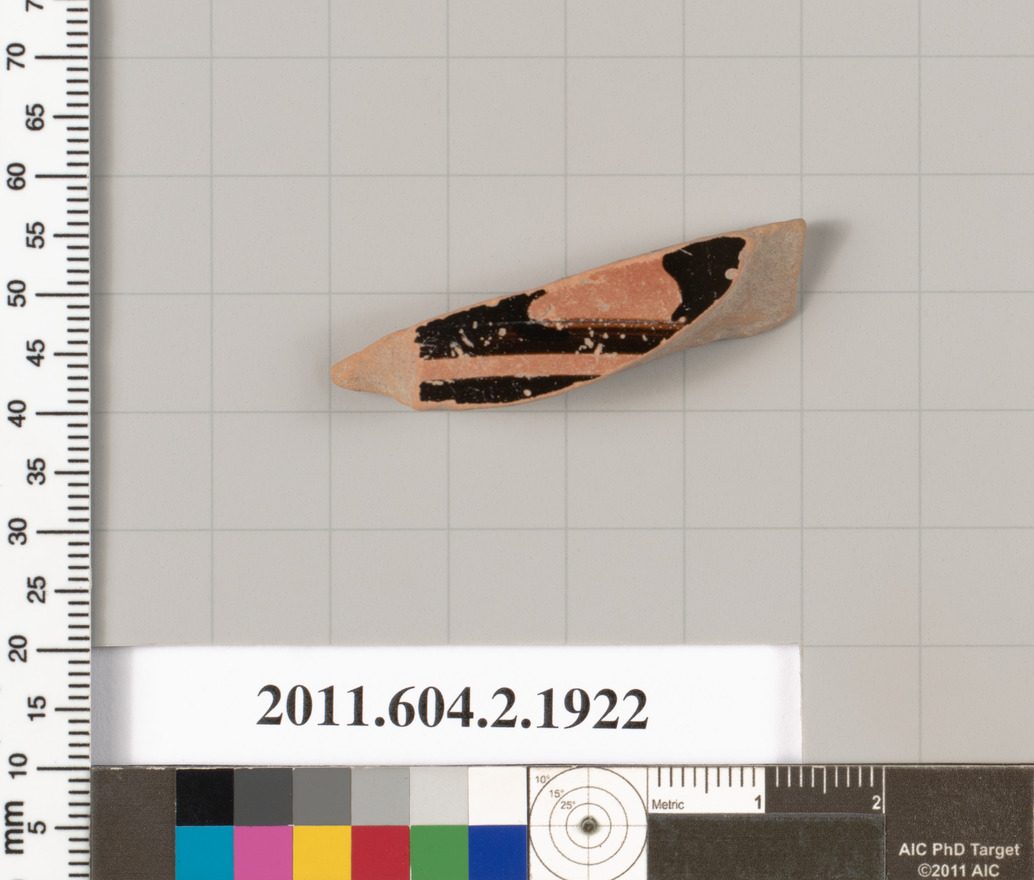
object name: skyphos fragment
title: Terracotta fragment of a skyphos (deep drinking cup)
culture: greek, attic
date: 450-401 BCE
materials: terracotta